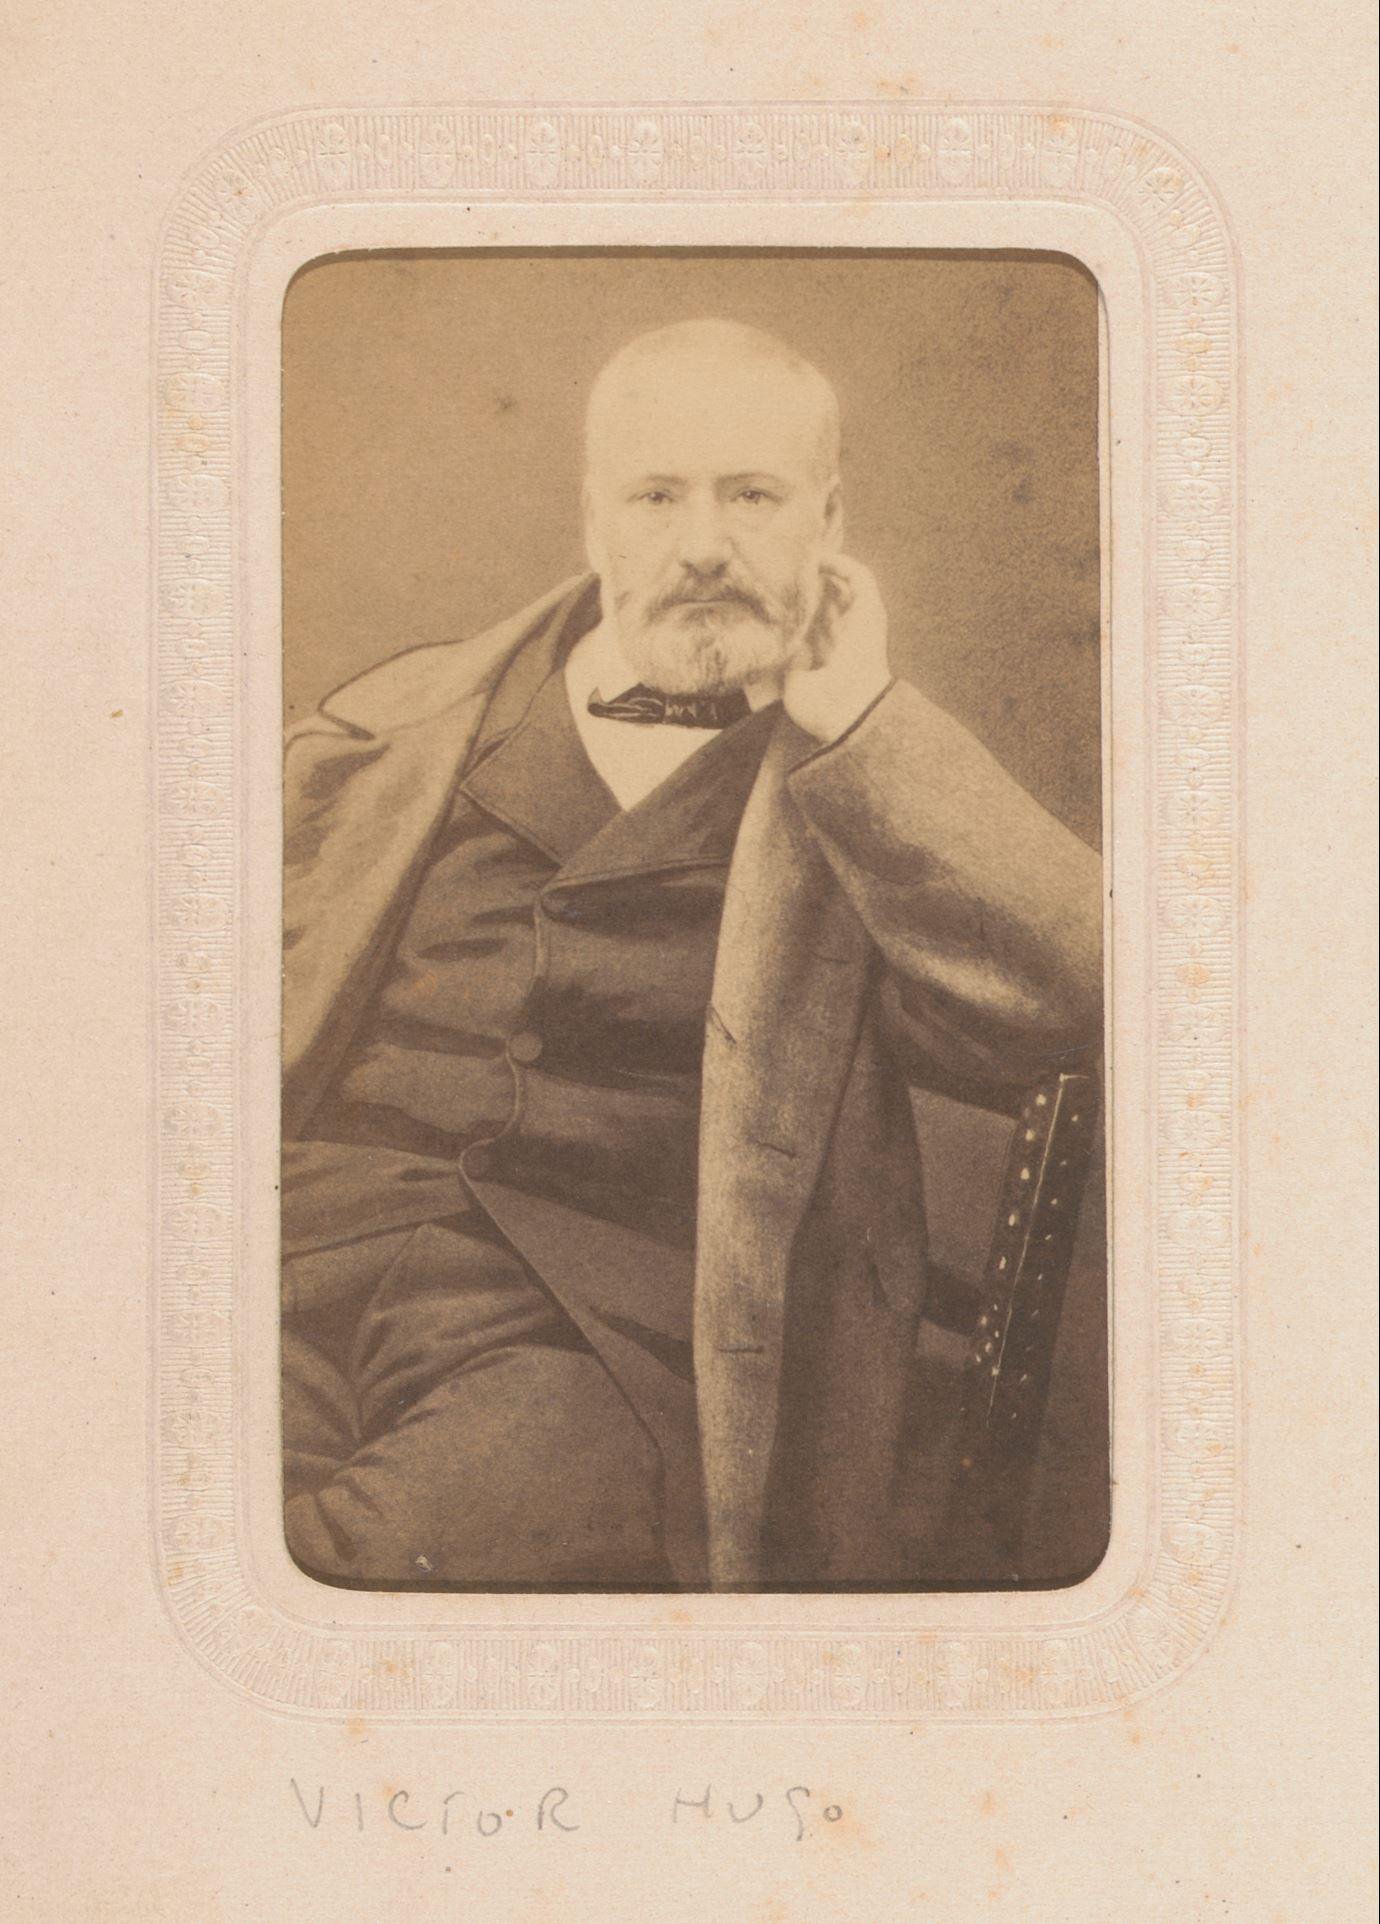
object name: carte de visite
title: Portret van Victor Hugo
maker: Anonymous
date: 1855-1865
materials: cardboard, photographic support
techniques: albumen print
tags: paris, victor hugo, historical persons, portrait of a writer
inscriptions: name: ‘Victor Hugo’